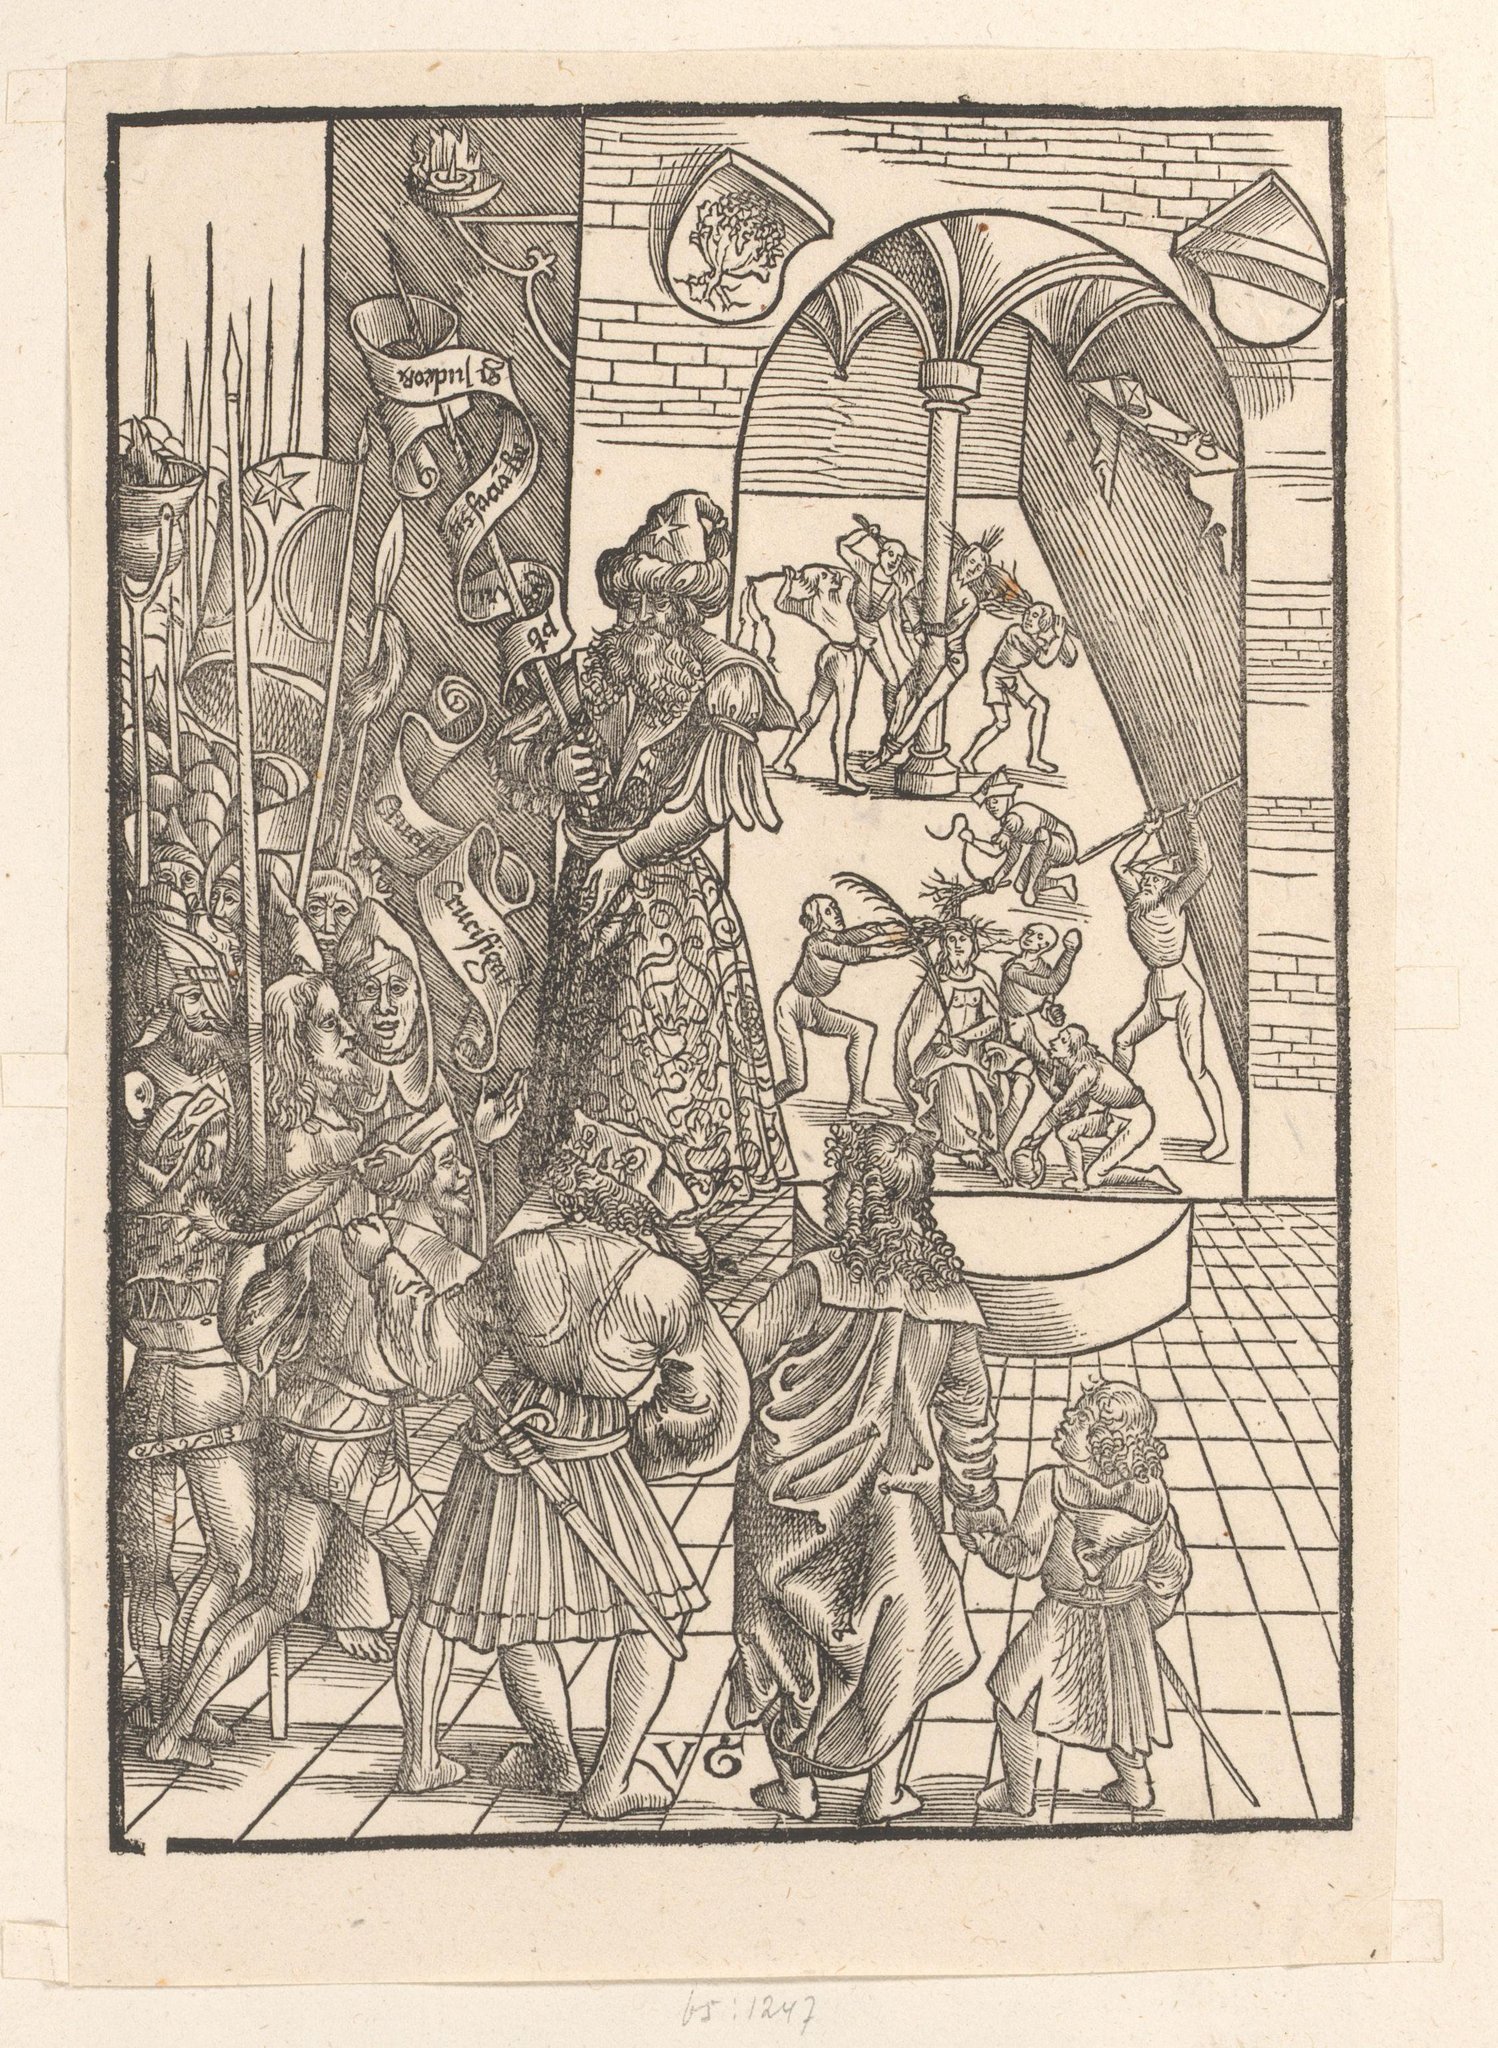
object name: album leaf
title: Leven en passie van Christus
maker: urs graf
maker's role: draughtsman, print maker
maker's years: 1485-1528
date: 1506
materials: paper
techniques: woodcut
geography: switzerland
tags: choice between christ and barabbas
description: Pilatus vraagt aan het volk of hij Christus of Barabbas moet laten kruisigen. Op de achtergrond wordt Christus gegeseld en bespot. Prent maakt deel uit van een album.